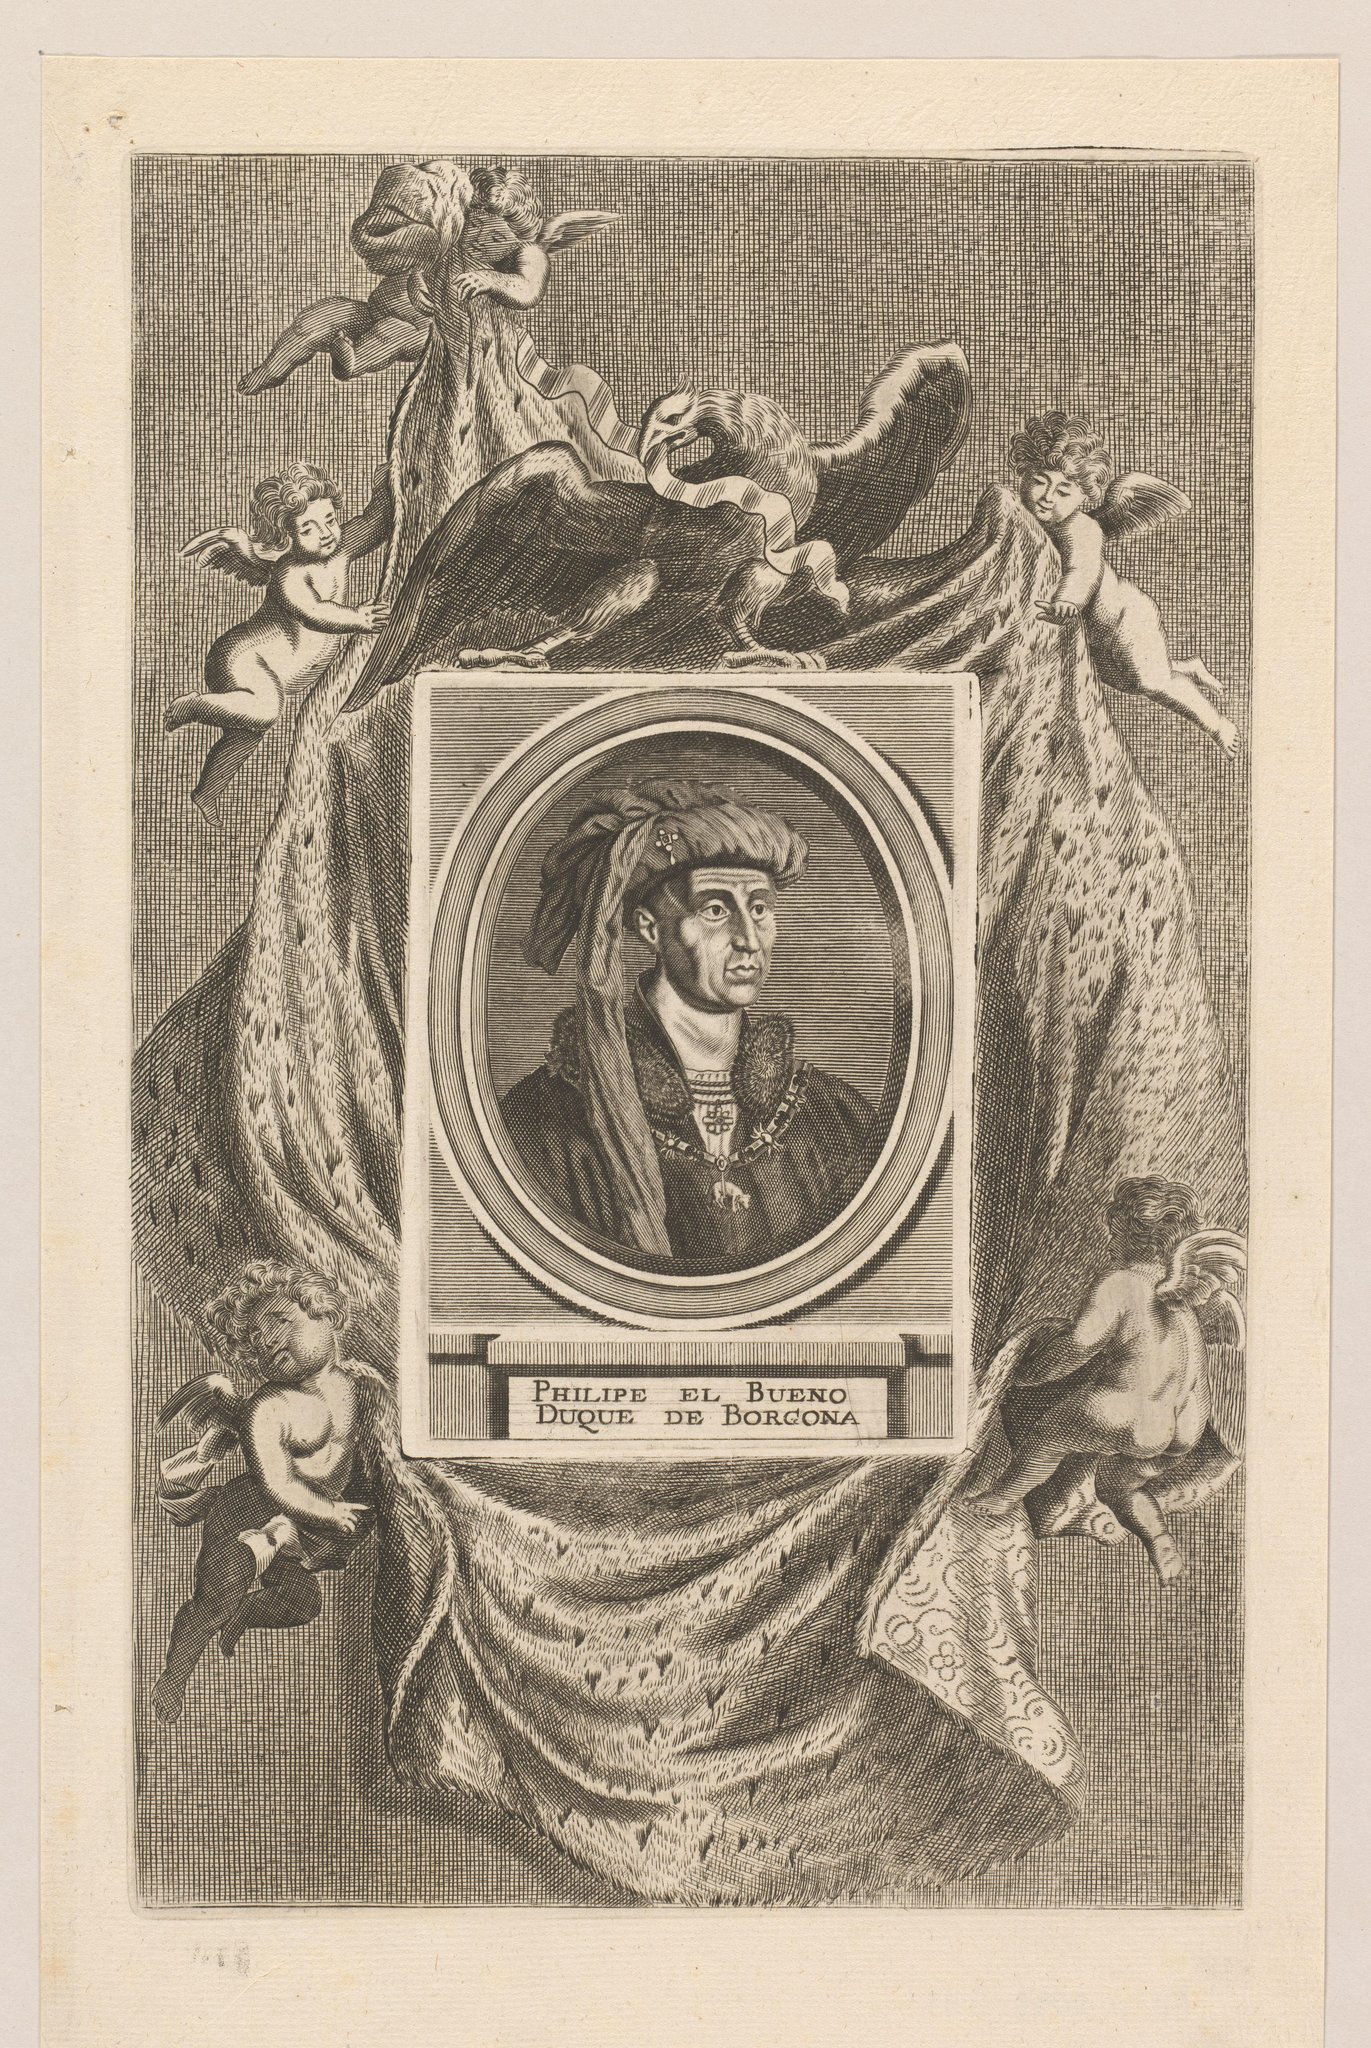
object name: book illustration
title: Portret van Filips de Goede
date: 1713-1714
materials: paper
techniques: engraving, etching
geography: low countries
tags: bruges, philip iii the good, other sovereign, historical persons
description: Prent waarschijnlijk uit: Komen, Filips van. Las Memorias (...). Antwerpen: Hendrik en Cornelis Verdussen, 1713, dl. 1. Of uit de editie uit 1714.